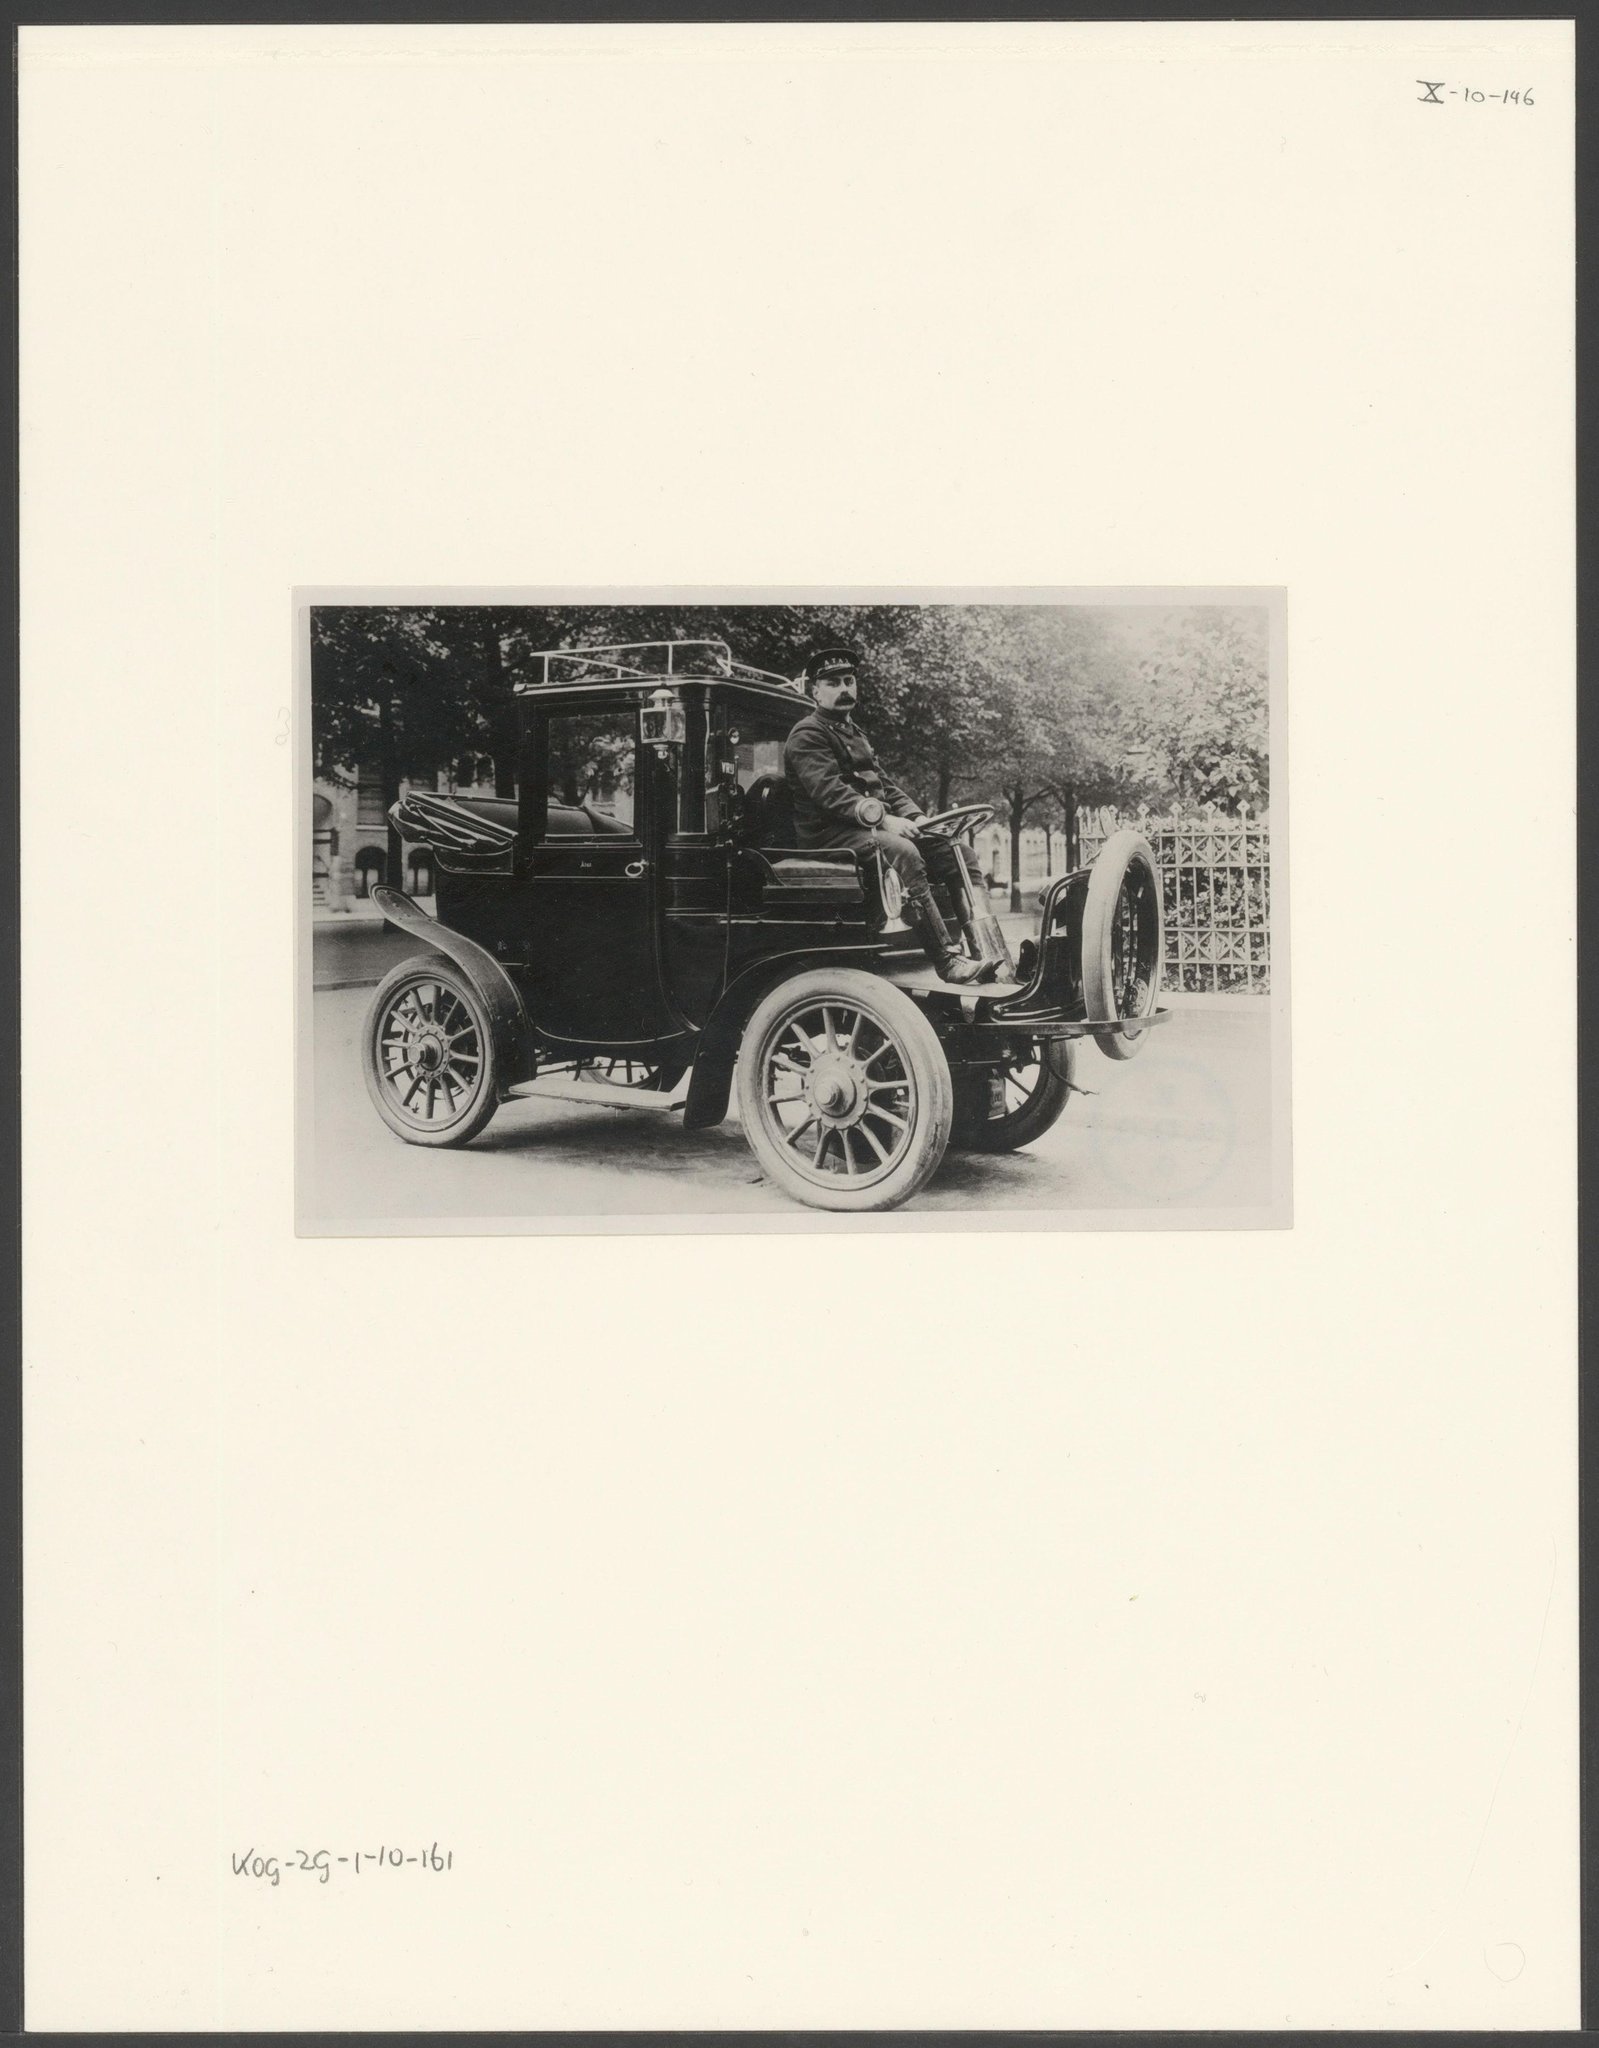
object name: photograph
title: Eerste Atax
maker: Anonymous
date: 1909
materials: paper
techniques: gelatin silver print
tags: automobile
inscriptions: stamp, collector's mark: Lugt 1641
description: De eerste Atax in Amsterdam. De Atax was een elektrische auto die vaak werd ingezet in de steden. Uiteindelijk werd de Atax eruit geconcurreerd door de benzineauto die harder ging. Onderwerpsrubrieken binnen de Atlas Zeden en Gewoonten: Handel, Nijverheid en Verkeer, Vervoermiddelen te land.